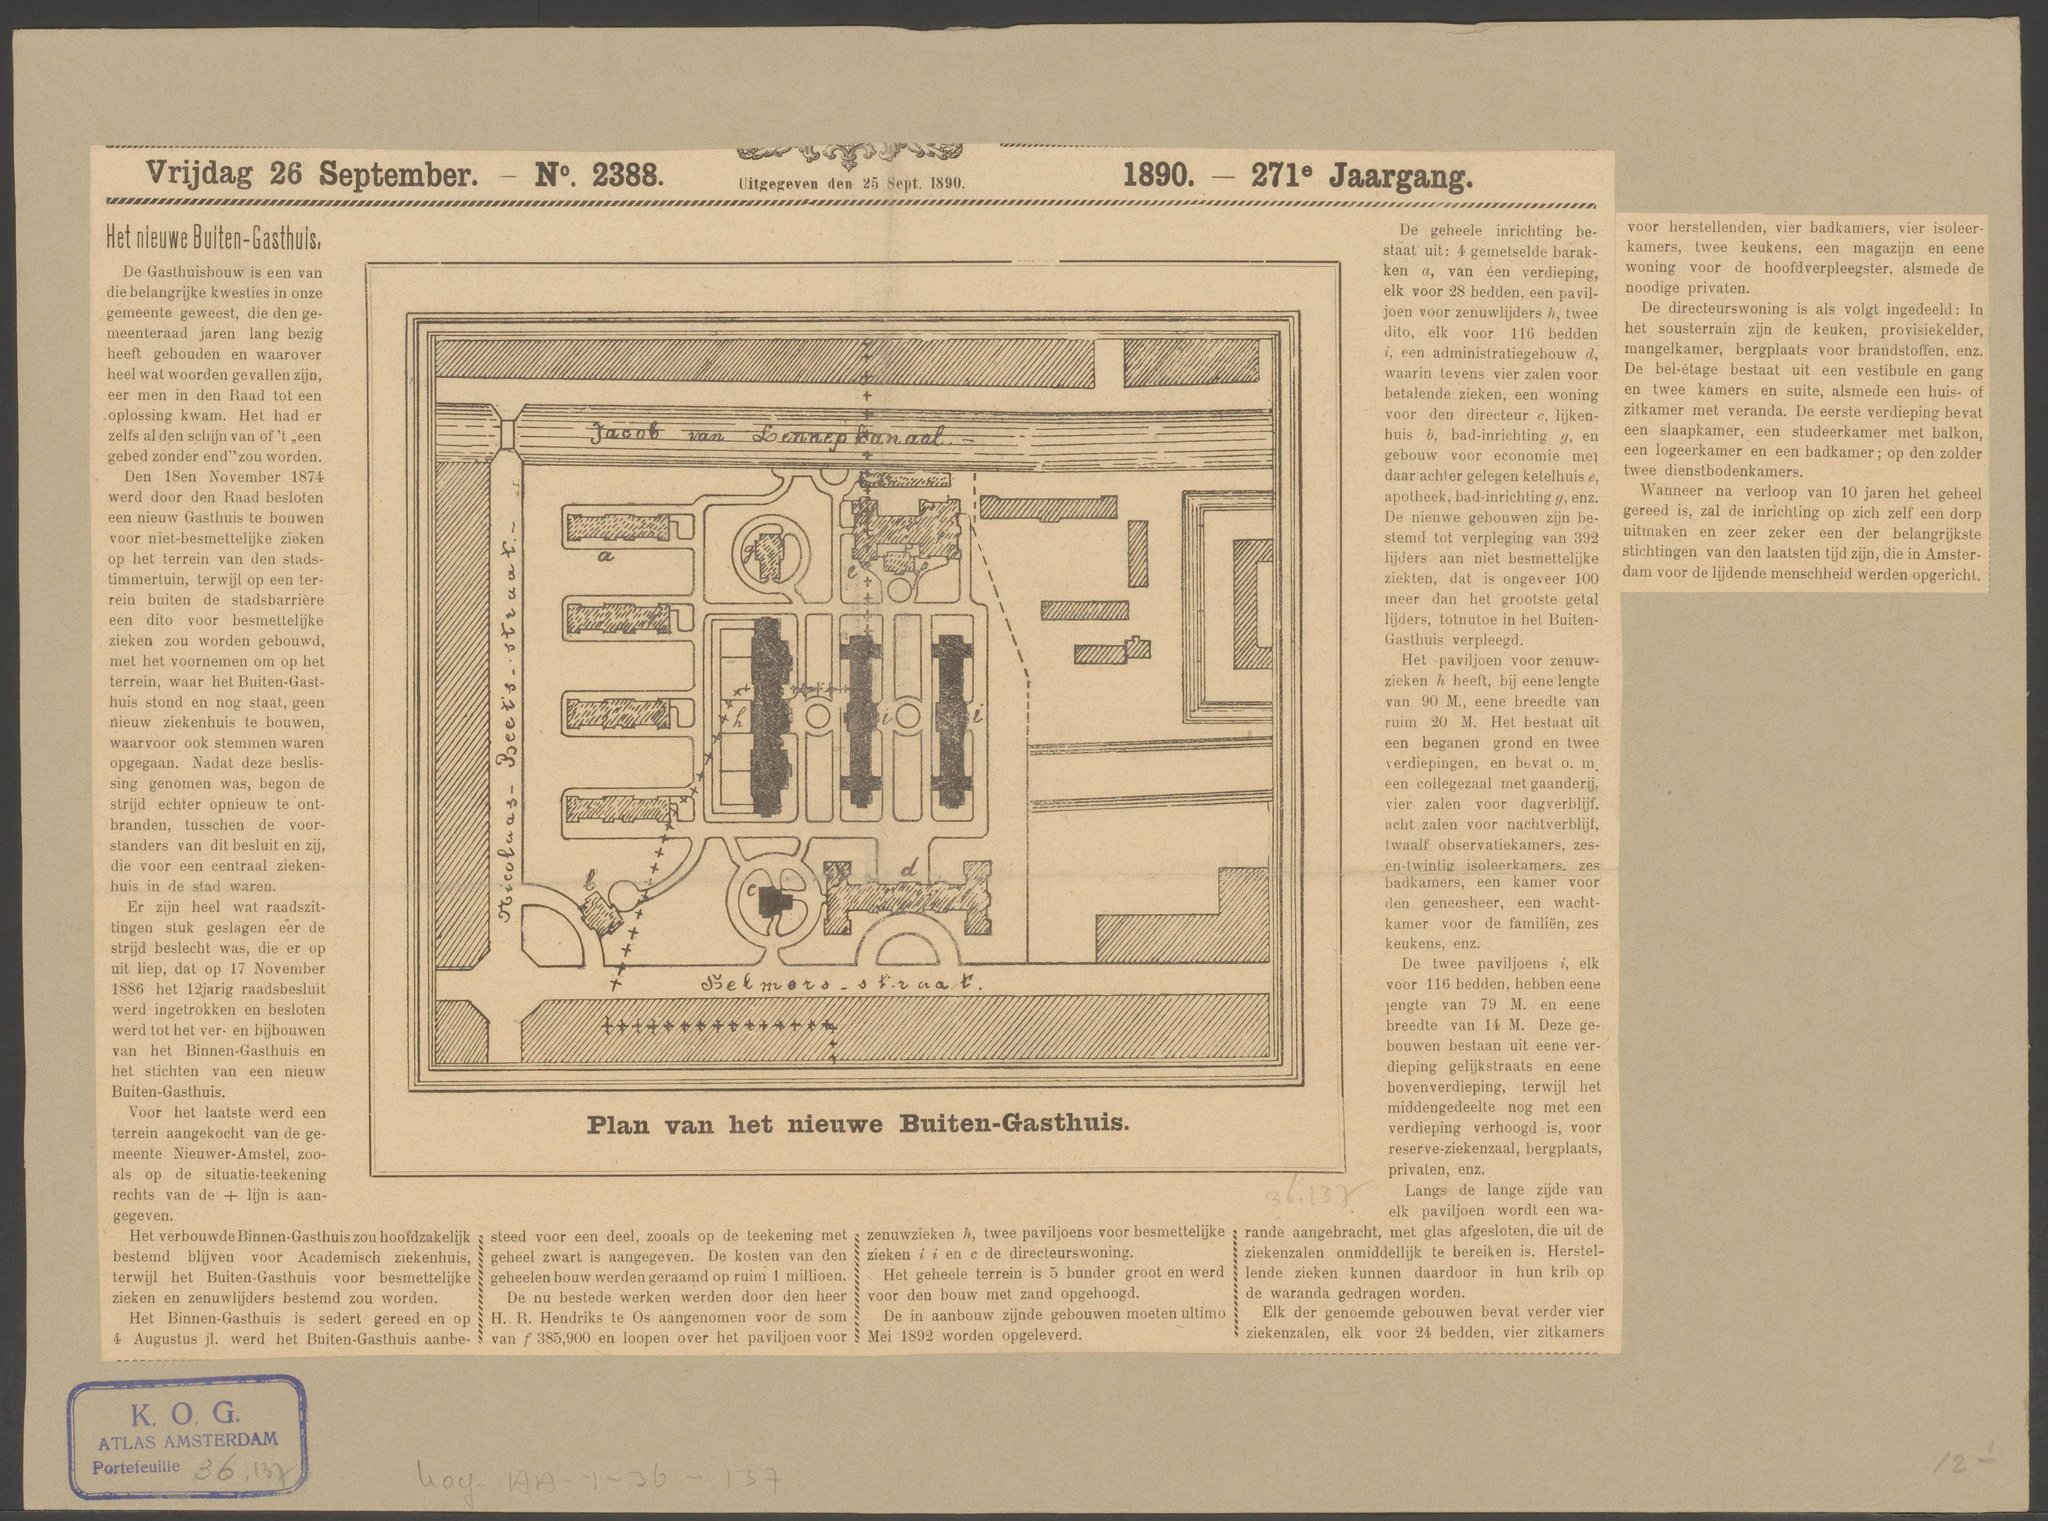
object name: photomechanical print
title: Plattegrond van het Wilhelmina Gasthuis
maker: Anonymous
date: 1890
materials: paper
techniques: letterpress printing, line block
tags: floor plan ~ architectural design or model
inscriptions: collector's mark: Lugt 1641b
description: Onderwerpsrubriek binnen de Atlas Amsterdam: Armwezen en liefdadige instellingen: I. Stadsinrichtingen: Wilhelminagasthuis.